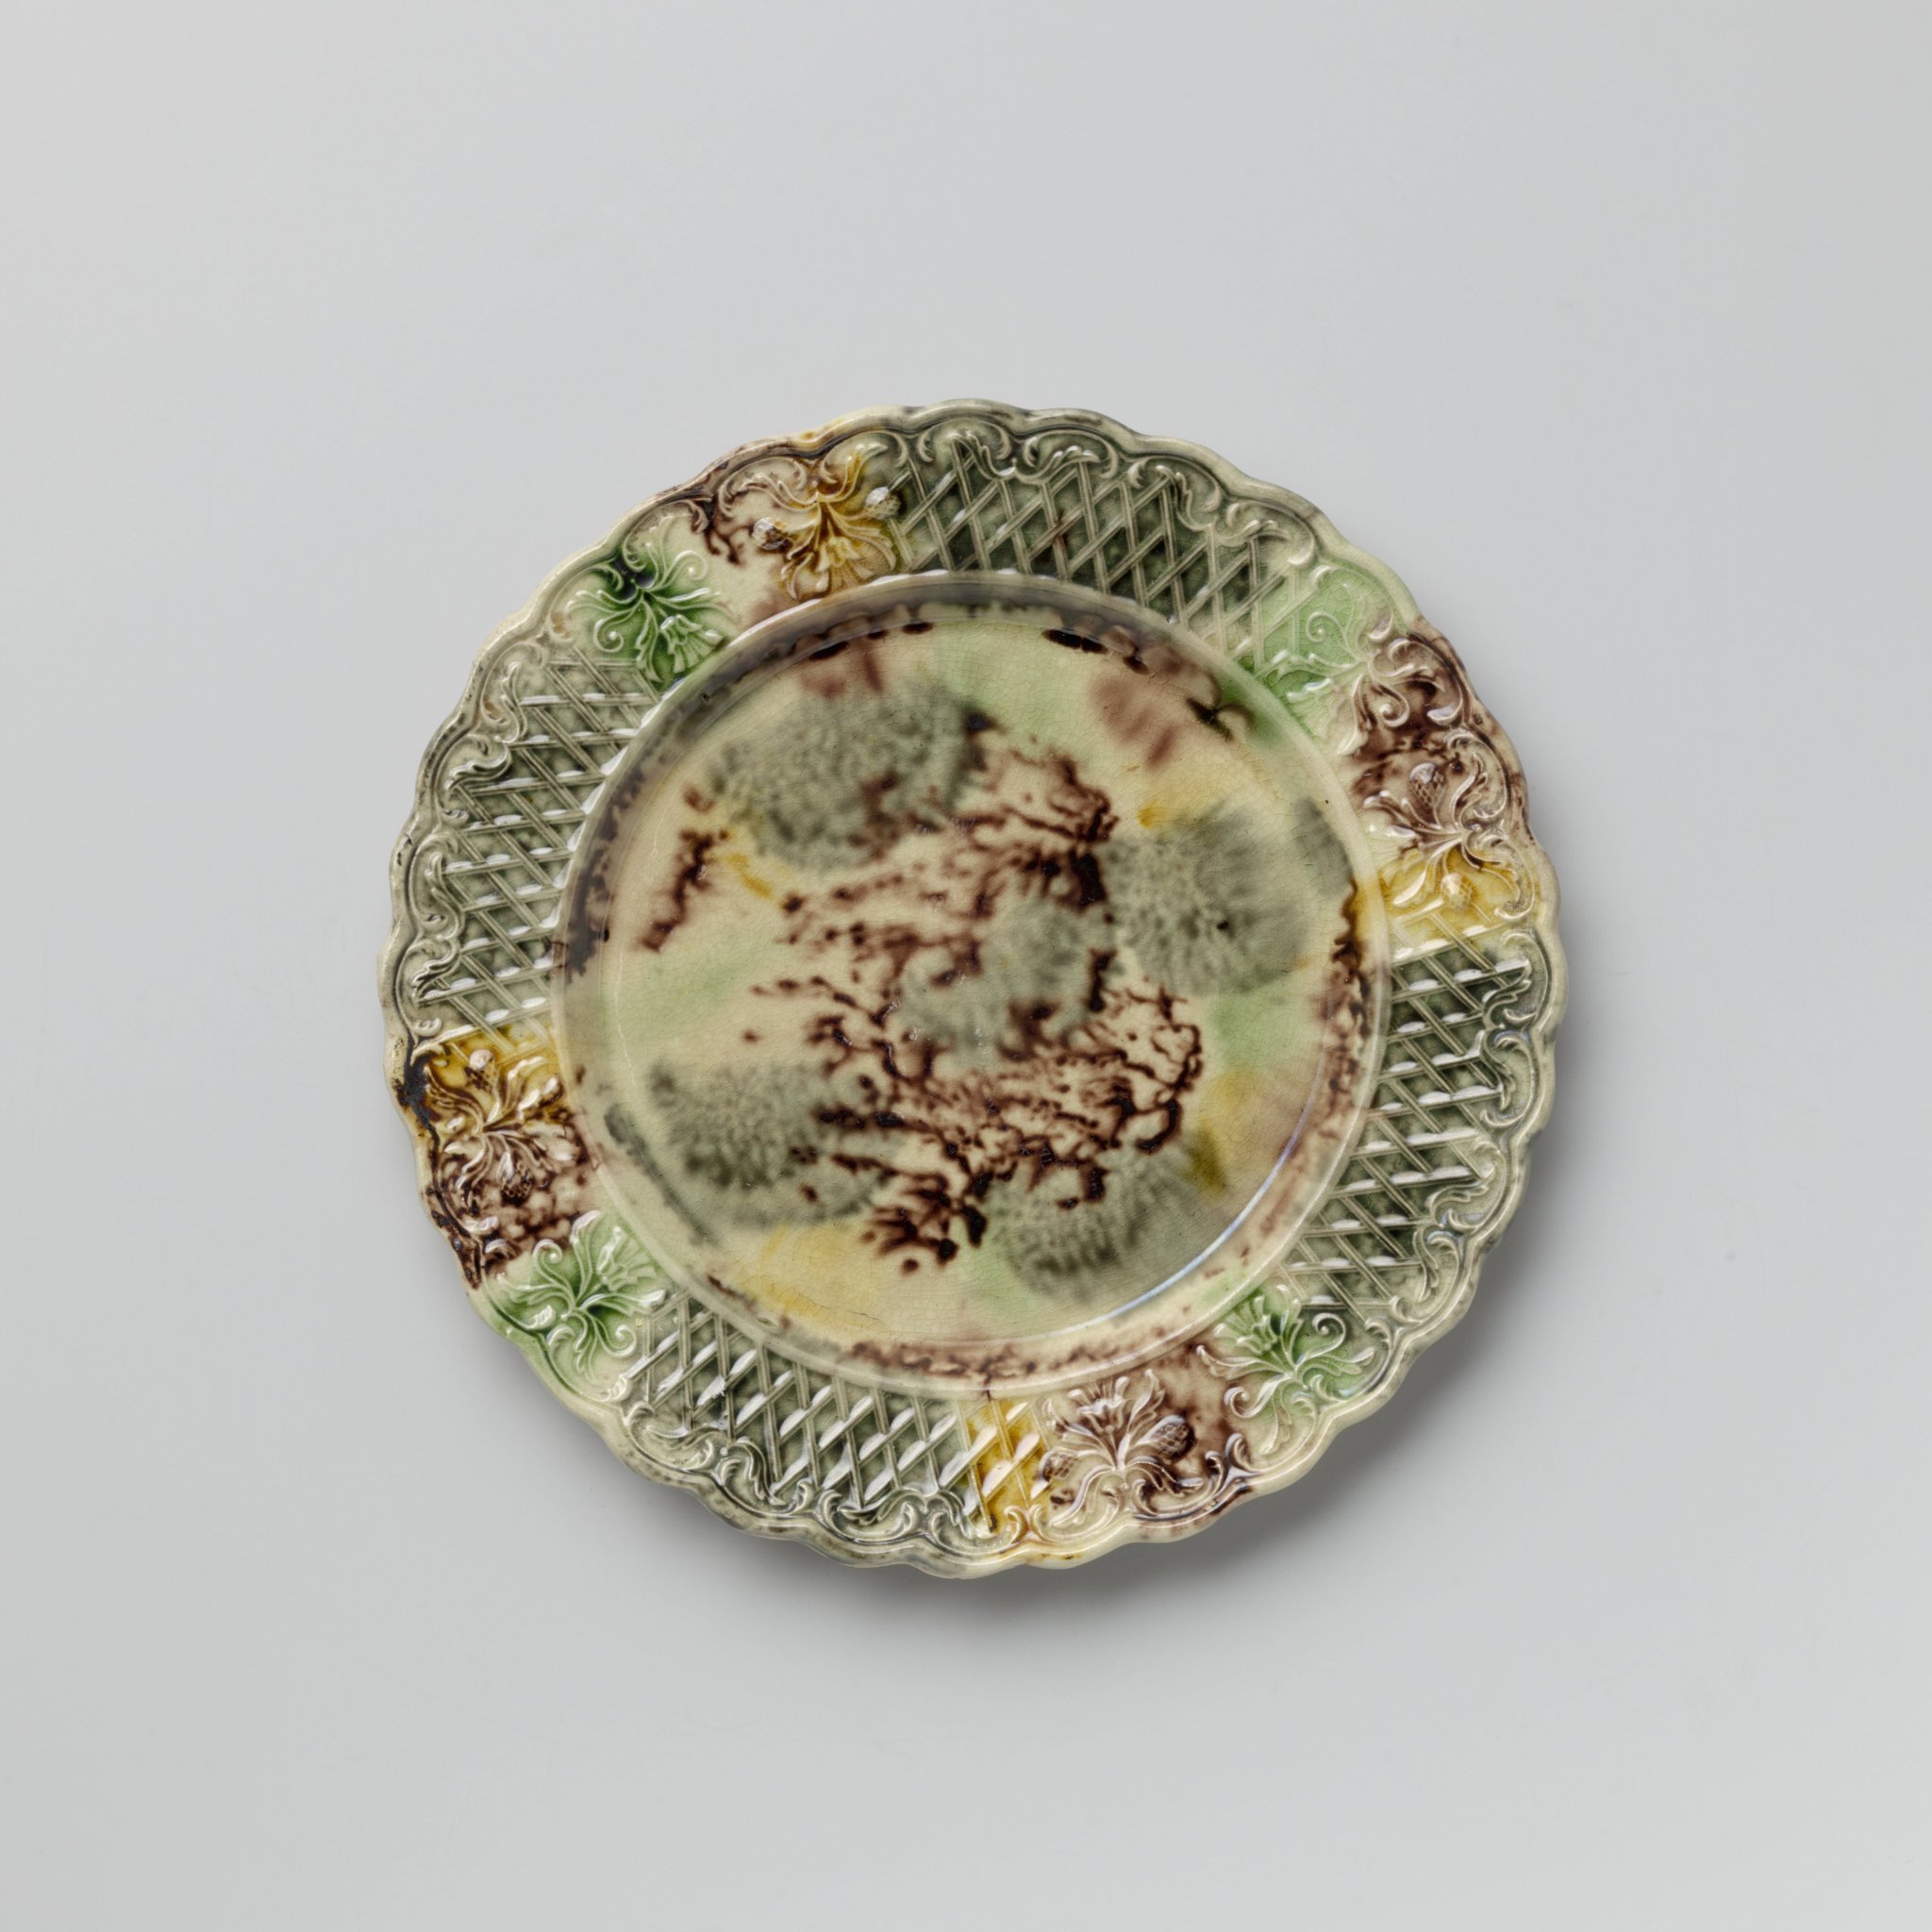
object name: plate dish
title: Bord van veelkleurig hardgebakken aardewerk; Staffordshire.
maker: Anonymous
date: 1750-1780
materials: earthenware, glaze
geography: england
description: Bord van veelkleurig hardgebakken aardewerk. De rand is in reliëf versierd met traliewerk, afgewisseld met twee naast elkaar geplaatste symmetrische bloemmotieven. De geschulpte rand is aan de binnenkant versierd met voluten en bladmotieven. Het bord is bedekt met een gevlekte loodglazuur in mangaan, groen, grijs en geel. De achterkant is in mangaan gestippeld en heeft een voetrand. Het bord hoort bij vijf borden (BK-1987-39-A t/m BK-1987-39-F).